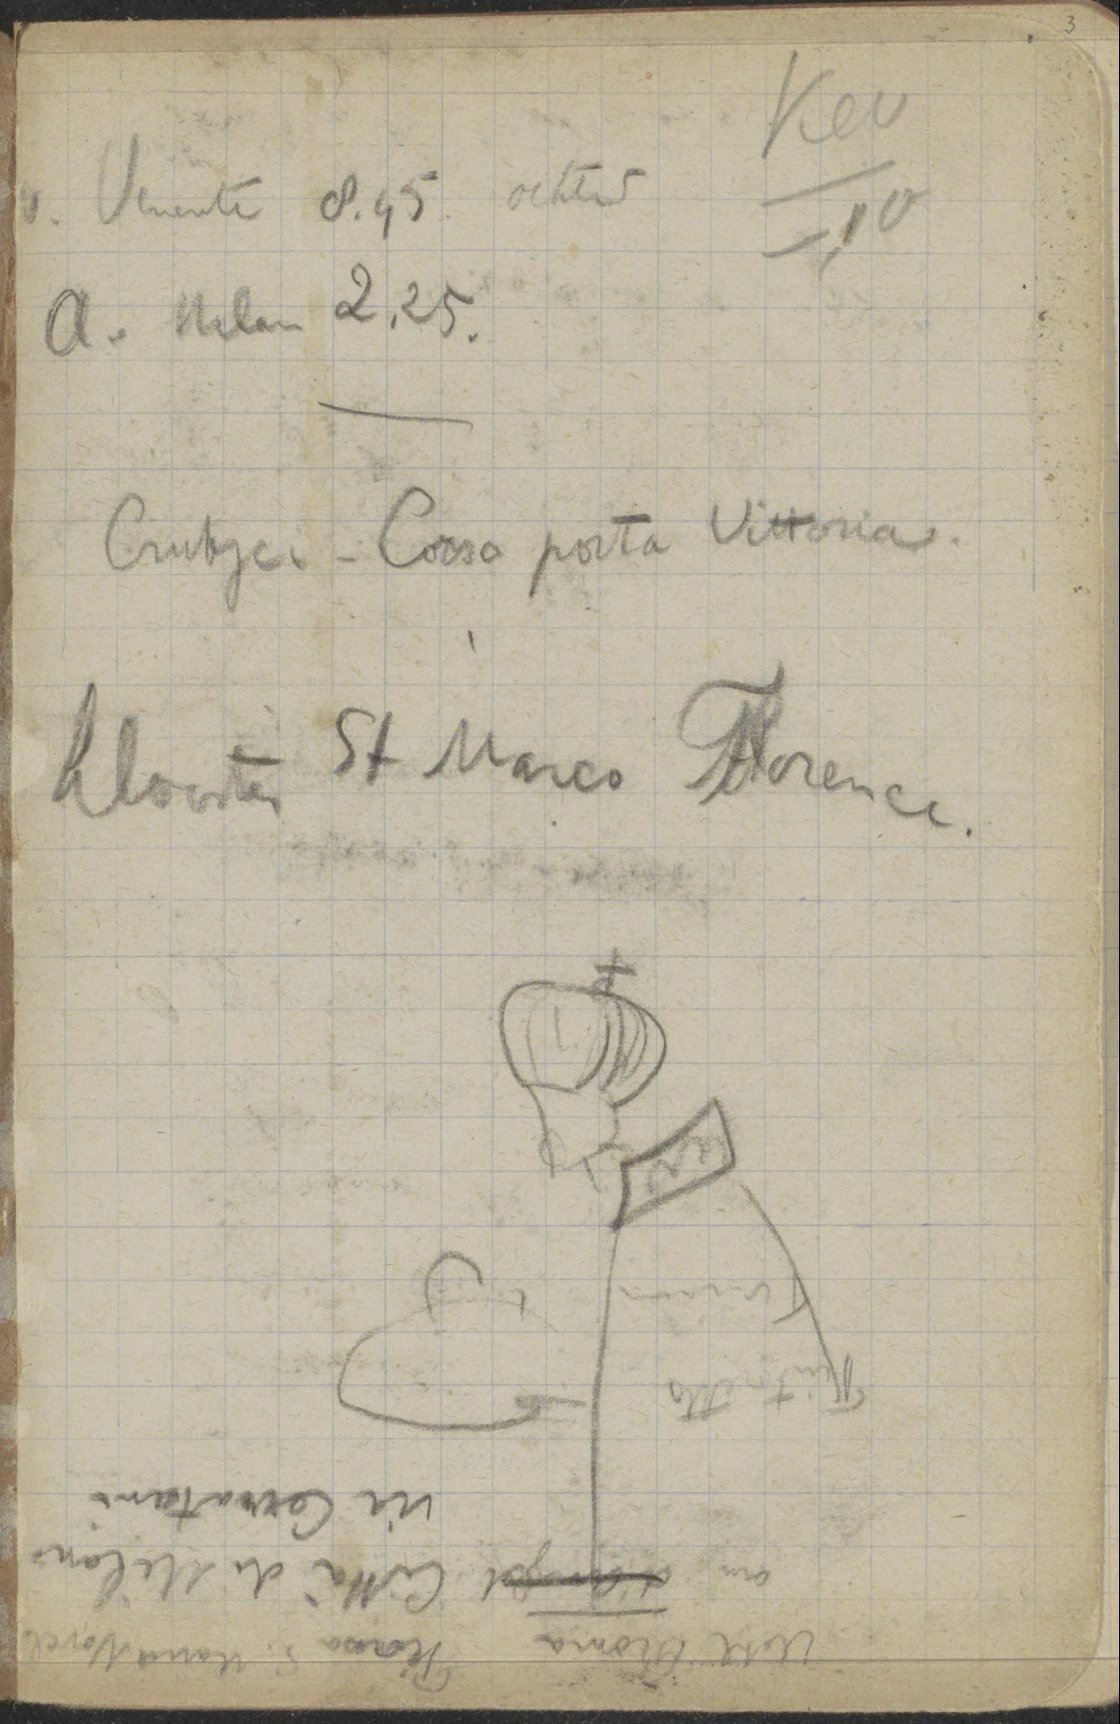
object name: sketchbook leaf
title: Figuur met een hoofddeksel met kruis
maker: marius bauer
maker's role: draughtsman, print maker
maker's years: 1867-1932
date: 1895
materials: chalk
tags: head-gear, the cross ~ symbols of christ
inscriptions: annotation: ‘v. Venetië 8.45. ochtend [...]/ a. Milaan 2.25./ [...] Corso porta Vittoria/ klooster St Marco Florence/ [...] Roma [...] S. Mana Novel/ Citta di Milano/ via Cerratani’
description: Mogelijk een bisschop. Pagina 1 uit een schetsboek met 28 bladen.